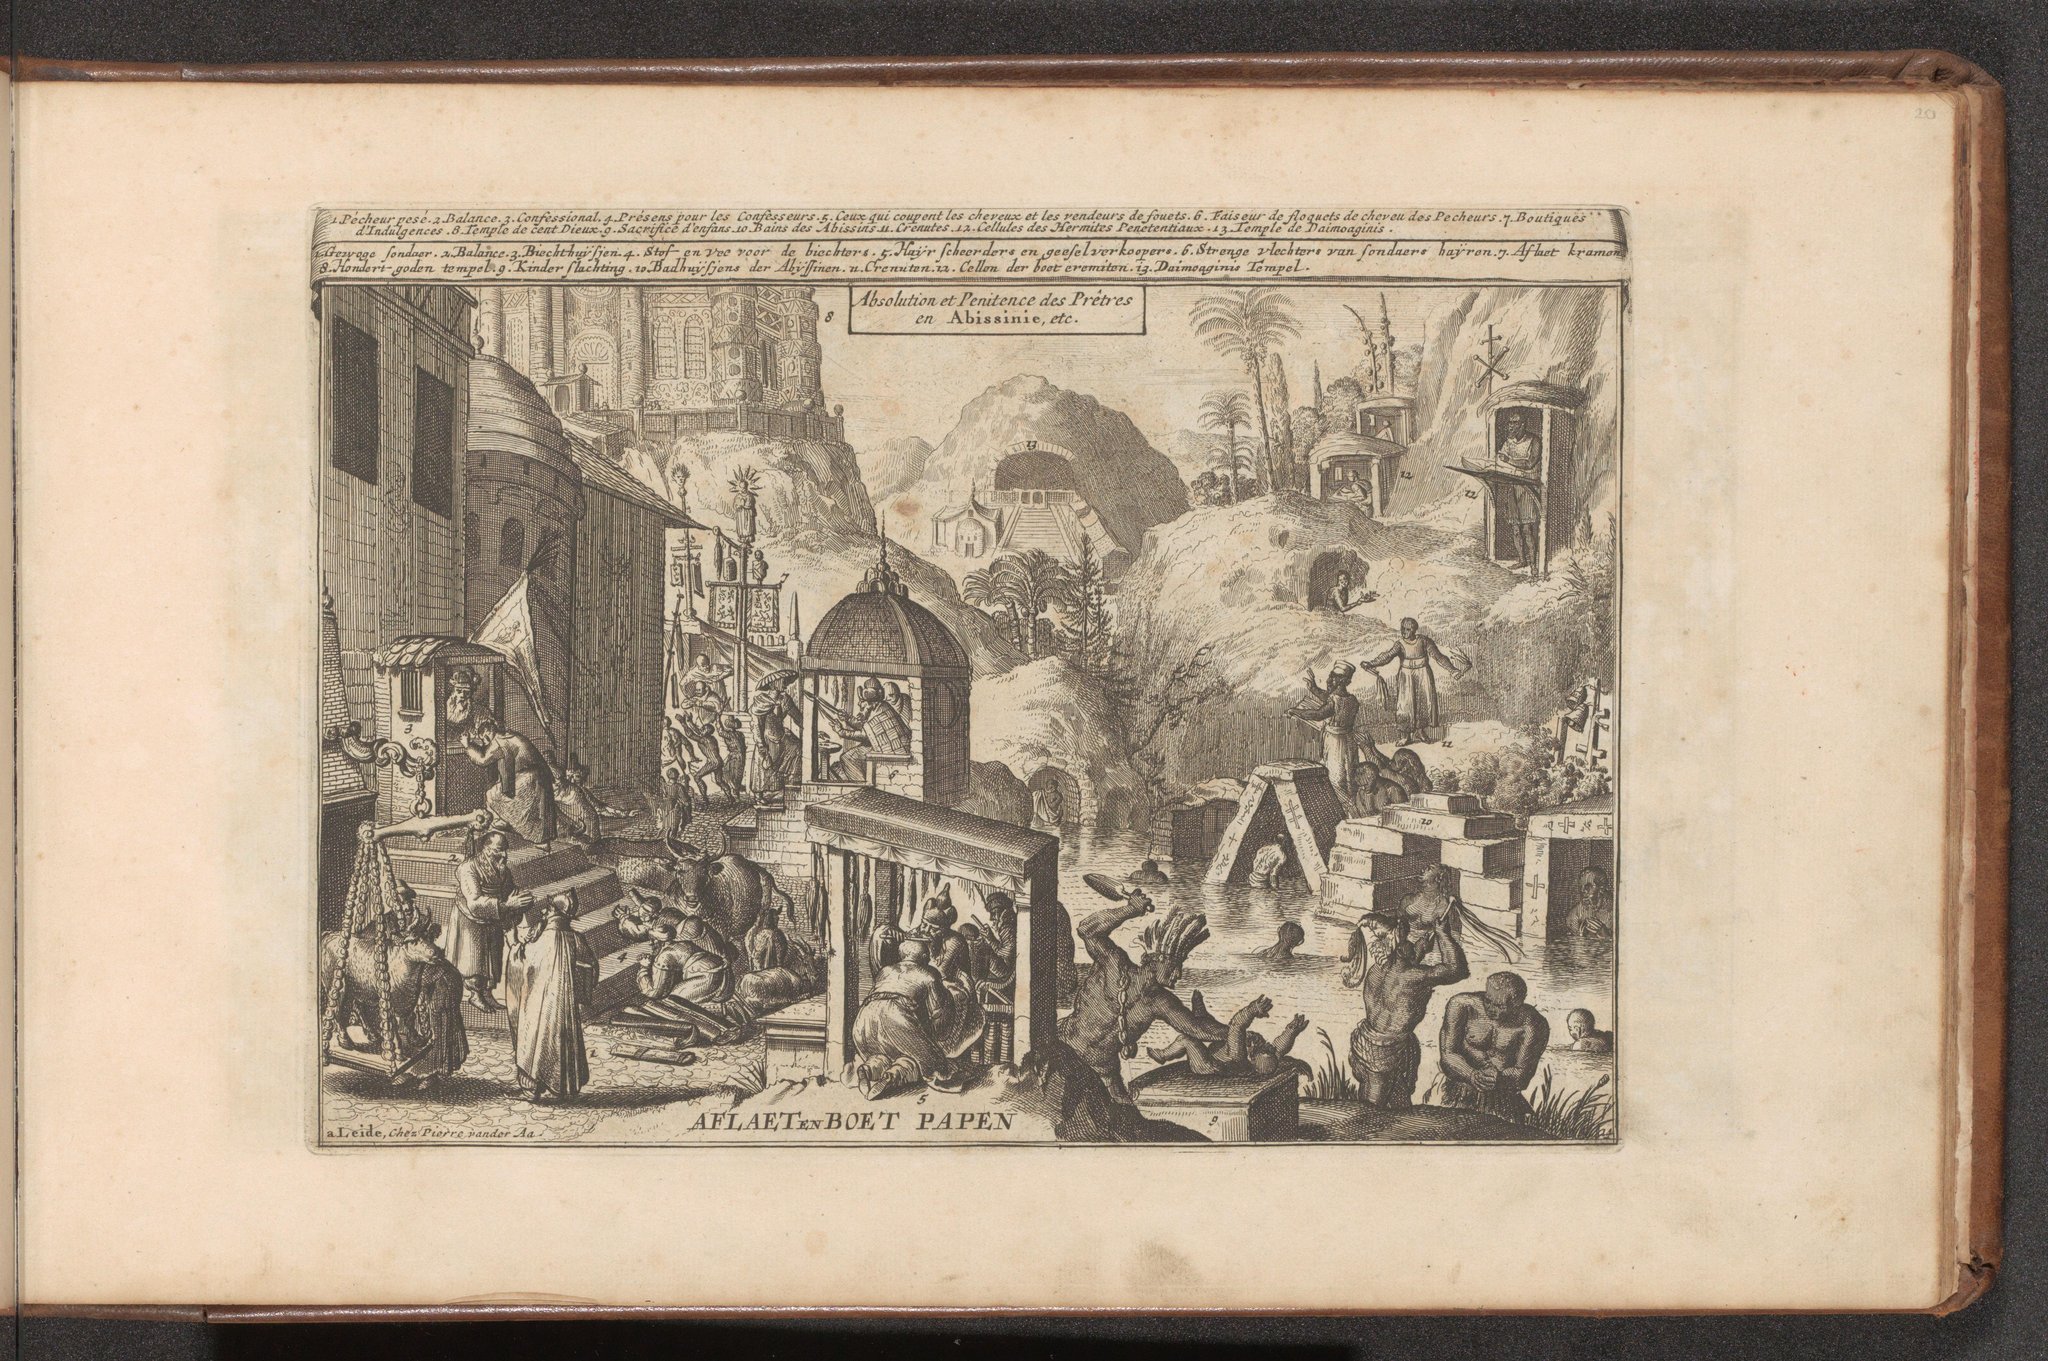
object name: print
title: Aflaet en Boet Papen / Absolution et Penitence des Prêtres en Abissinie, etc.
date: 1682-1733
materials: paper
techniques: etching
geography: leiden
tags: public penance, general avowal of faults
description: Landschap met aspecten over zonde en boete. Geheel links wordt een zondaar gewogen bij een trap met bovenop een biechthuis. Op de voorgrond bij een kraam met gesels laat een man zijn haar afscheren. De haren van zondaars worden gevlochten. Rechts op de voorstelling wordt een kind geslacht en pijnigen mannen zichzelf met een gesel. Op de achtergrond enkele heremieten. Met een legenda in het Nederlands en het Frans. De prent maakt deel uit van een album.